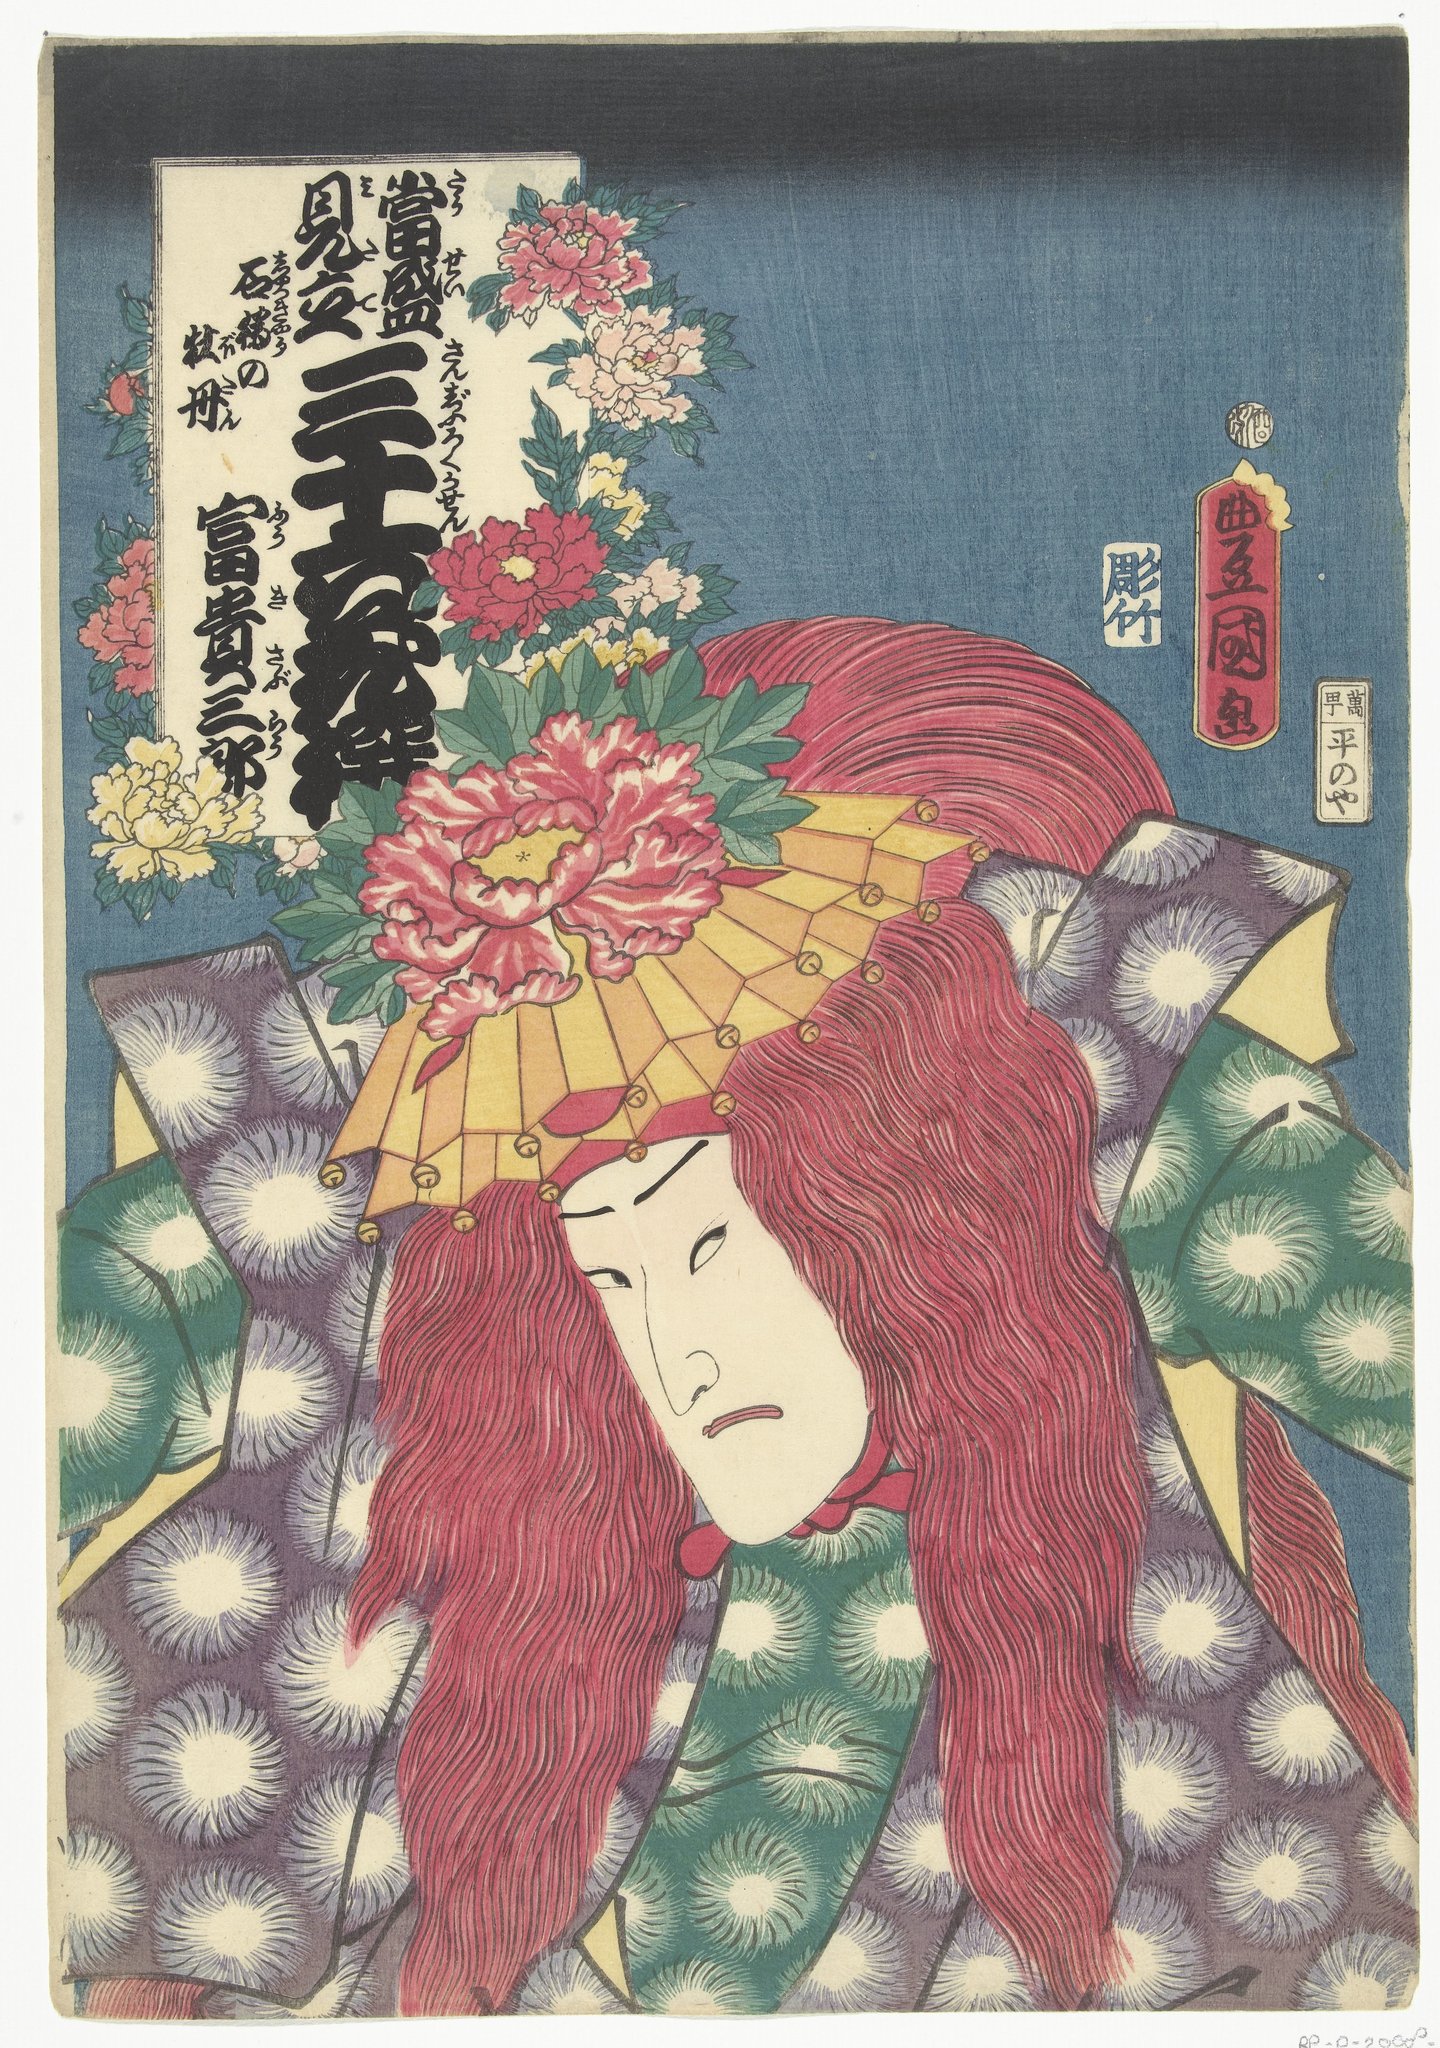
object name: print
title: Tosei mitate sanjurokkasen.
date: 1861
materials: paper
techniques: woodcut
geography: japan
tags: plants and herbs: peony, actor (on the stage)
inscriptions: date